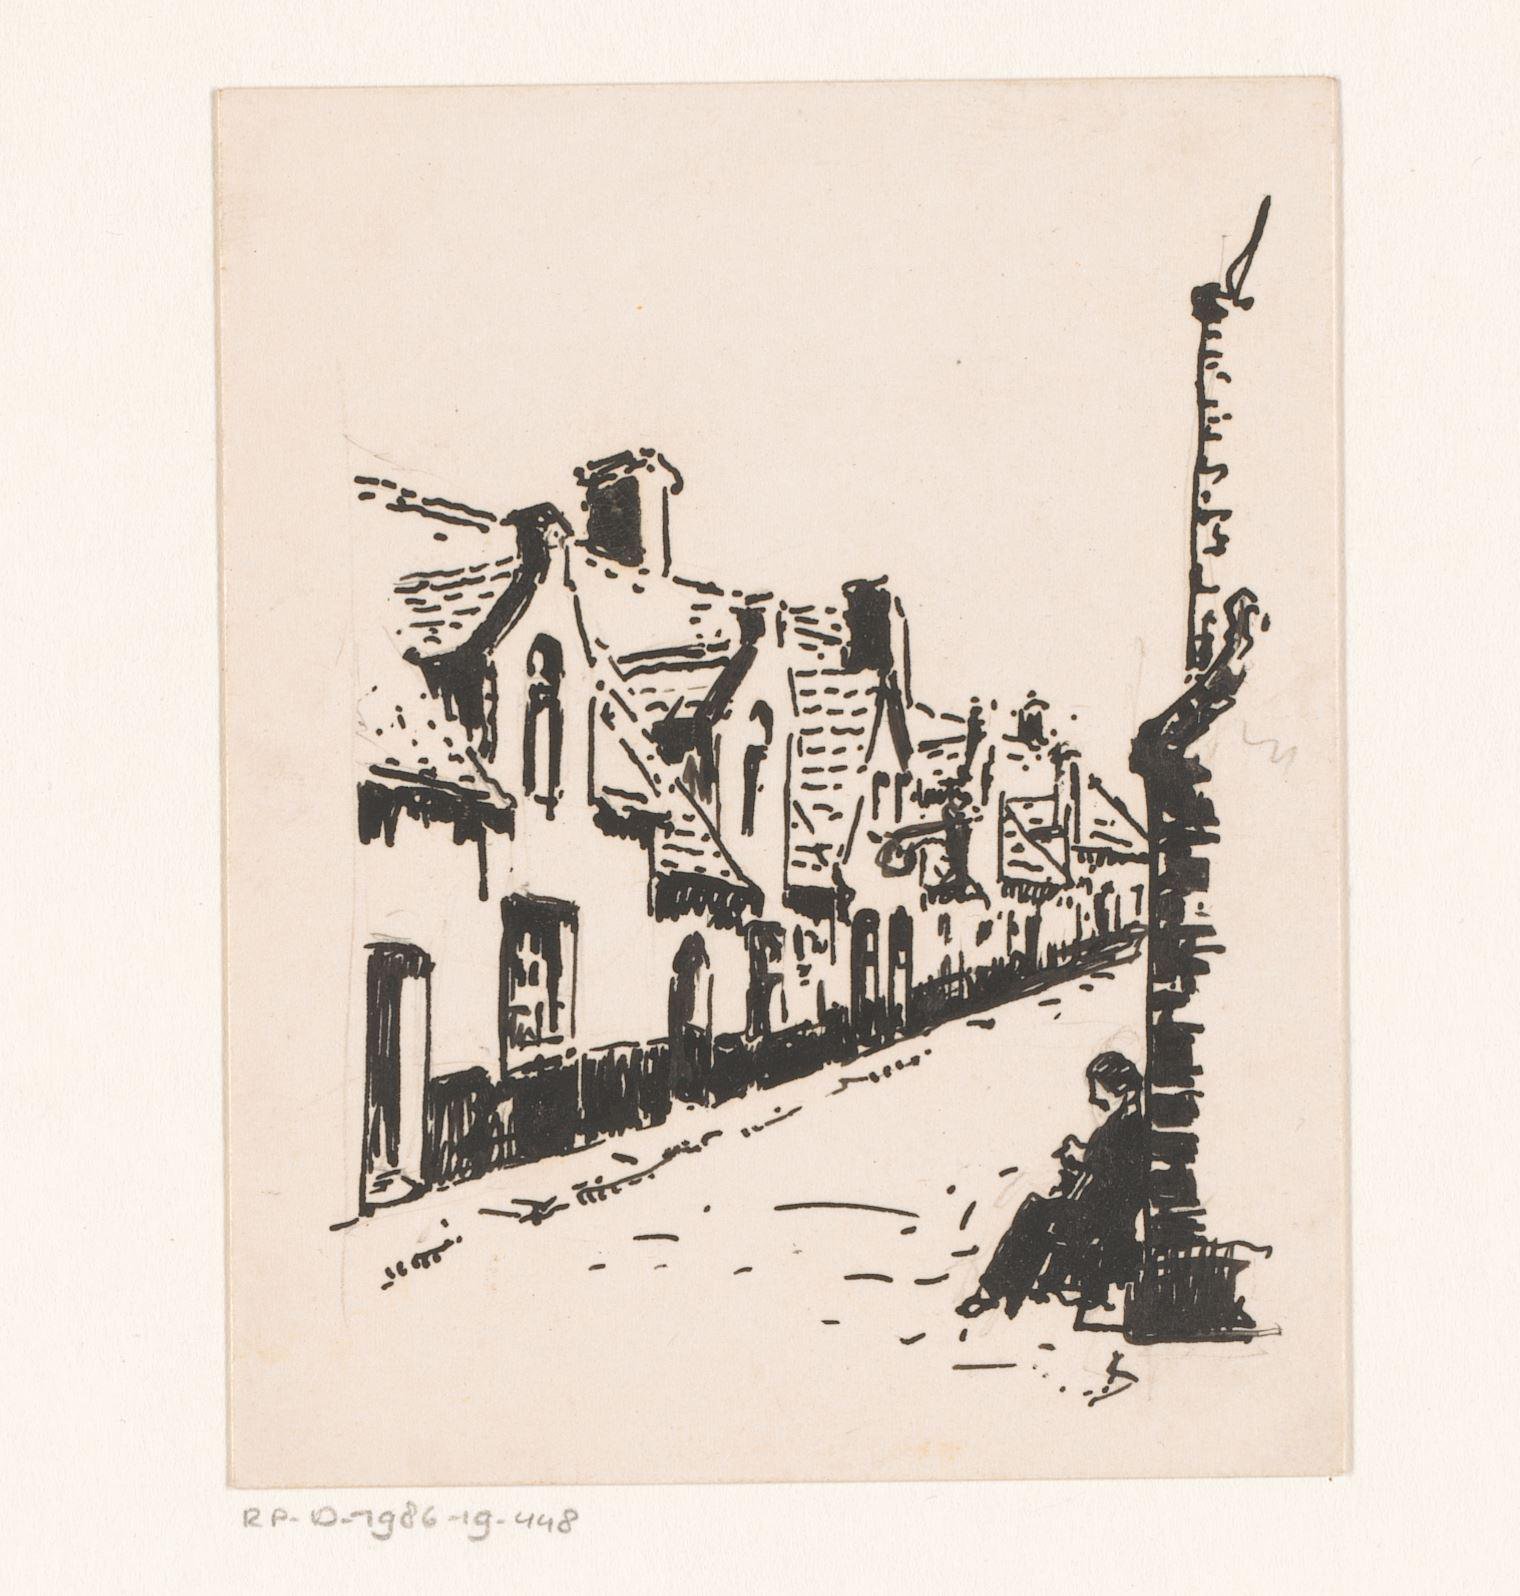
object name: drawing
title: Straat met zittende man bij een muur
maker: reinier willem petrus de vries (1874-1953)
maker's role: draughtsman, print maker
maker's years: 1874-1953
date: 1884-1952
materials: ink, paper, pencil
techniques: pen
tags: sitting figure, street (+ city(-scape) with figures, staffage)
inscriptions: collector's mark: ‘R:MVS.’